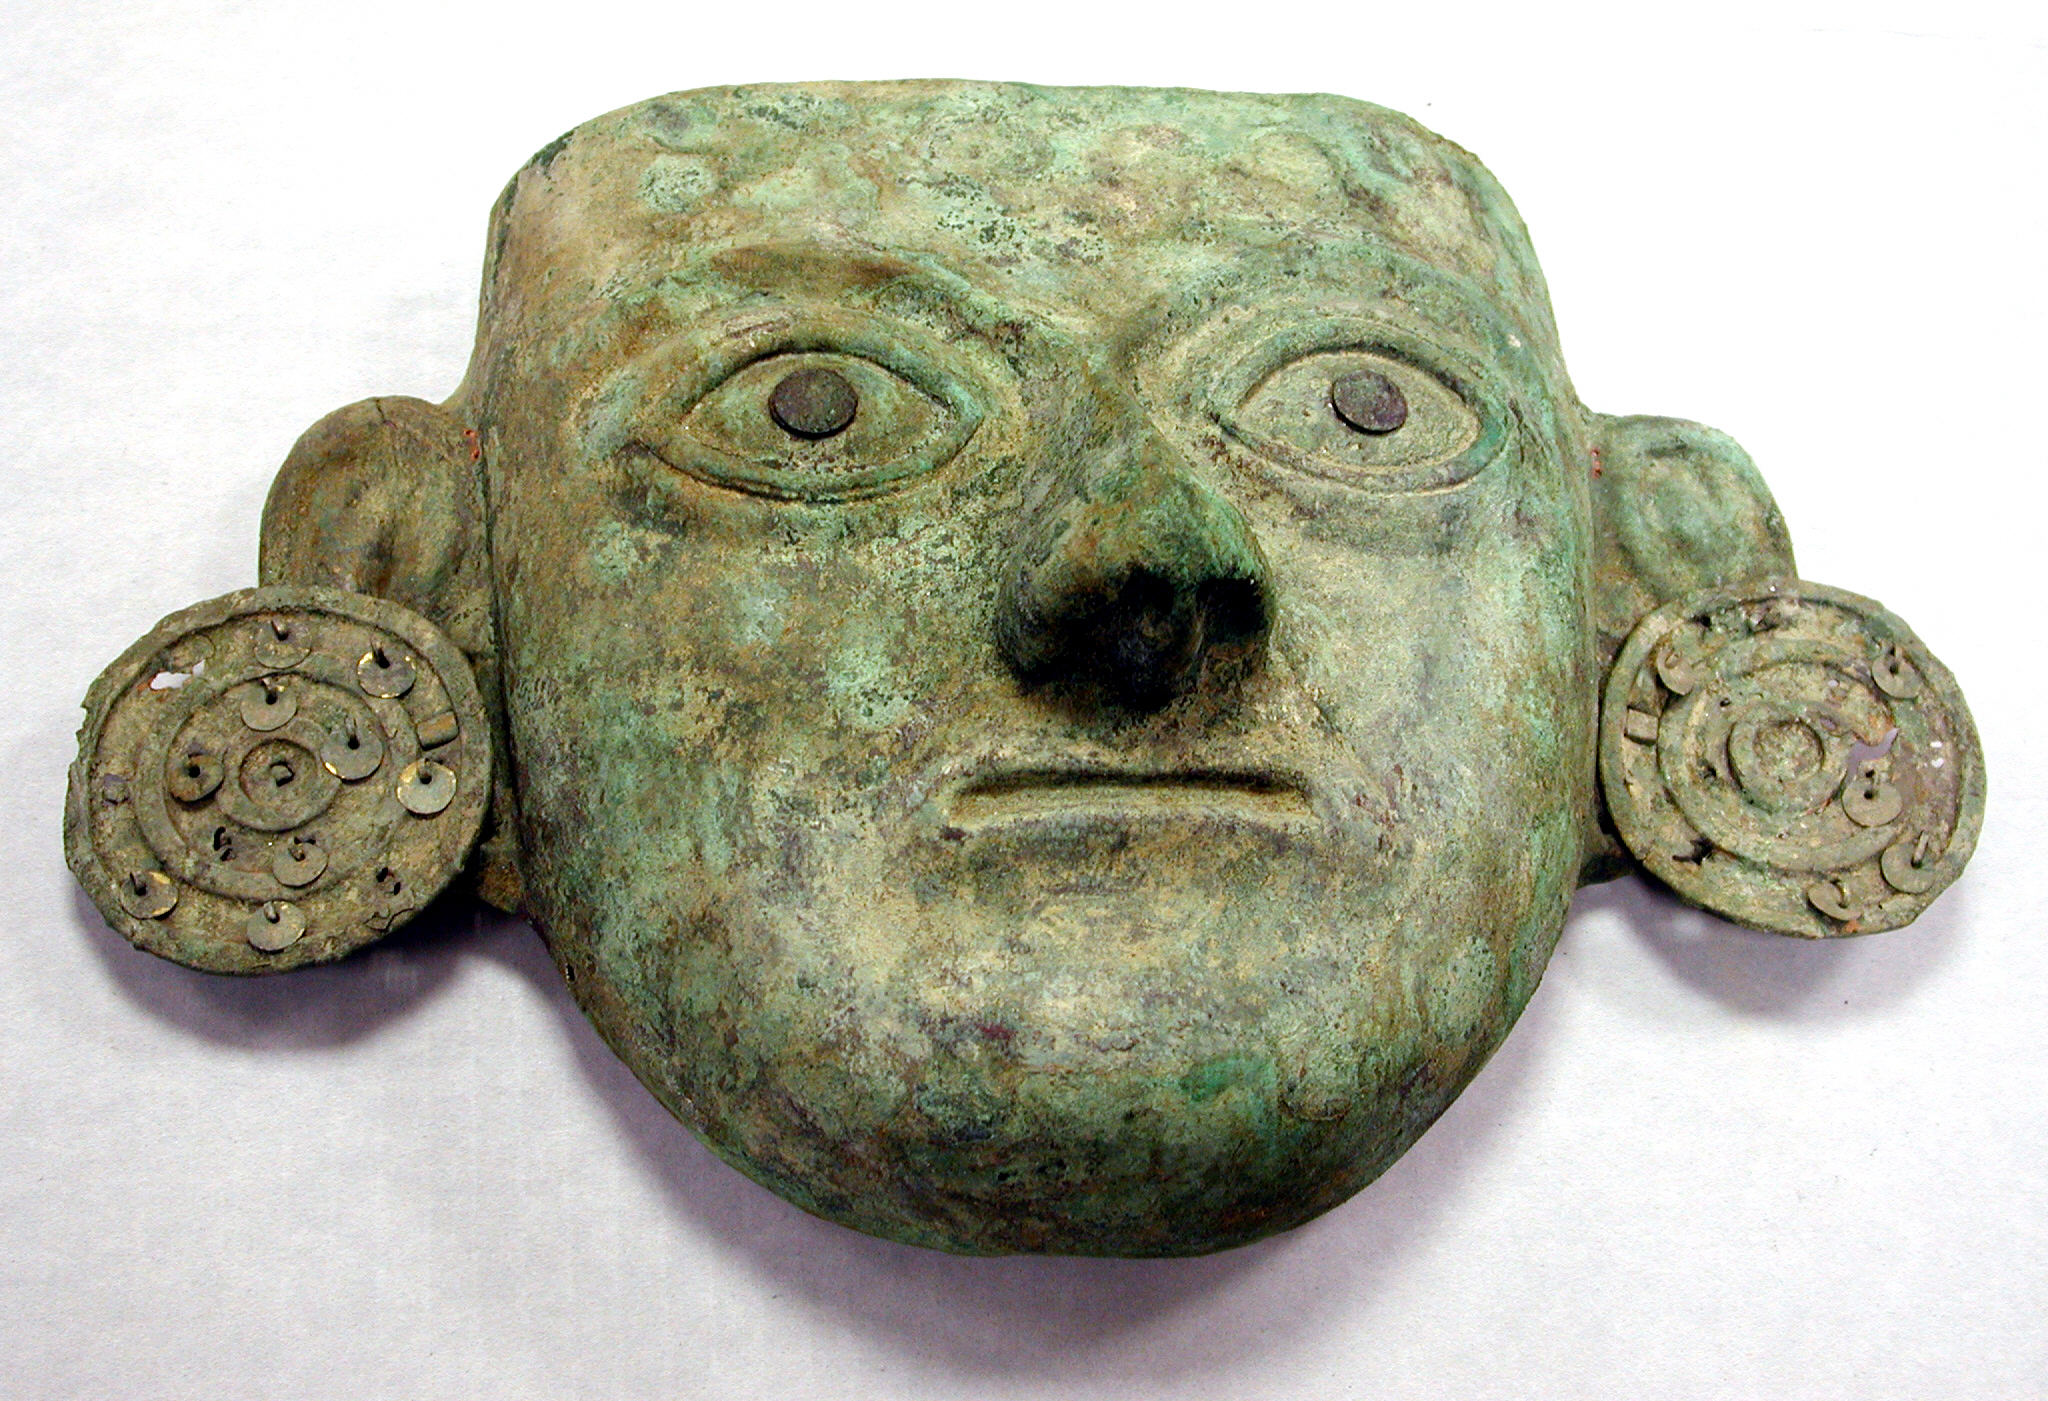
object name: mask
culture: moche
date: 101-700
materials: copper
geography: peru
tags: faces